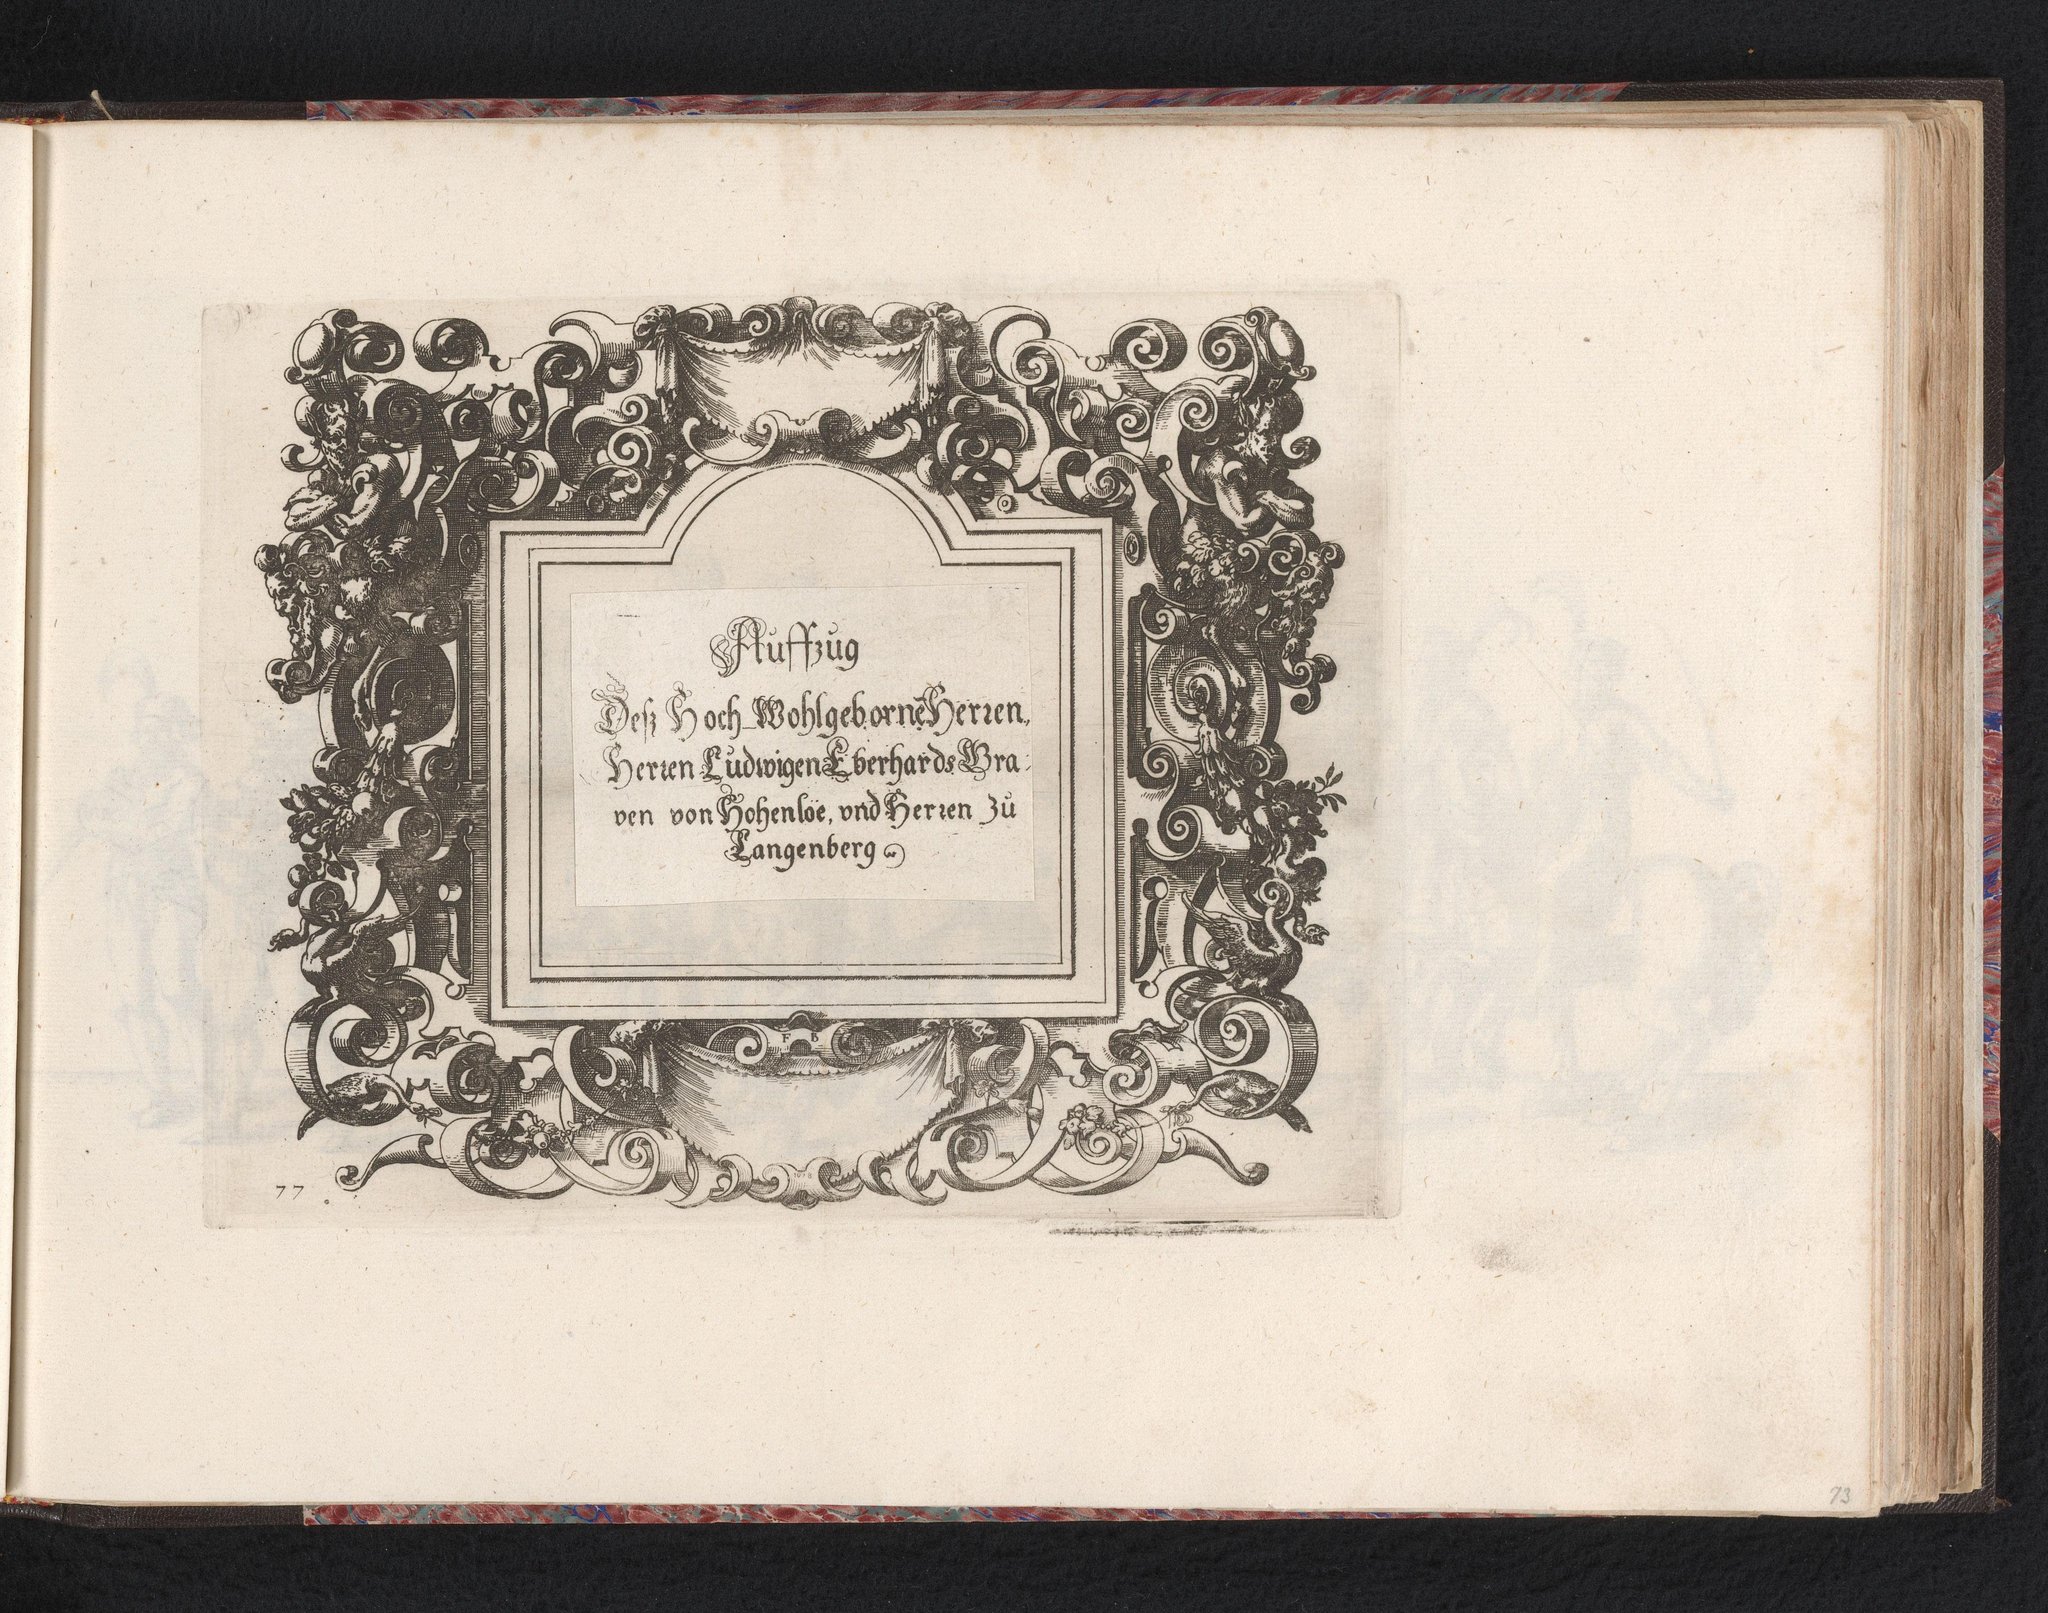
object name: album leaf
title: Band- en rolwerk met saters om een cartouche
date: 1618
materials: paper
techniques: etching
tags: earl, ludwig eberhard von hohenlohe-waldenburg-pfedelbach, satyrs, fauns, sileni, 'laub- und bandelwerk' ~ ornament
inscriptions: date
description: Genummerd: 77. Deze prent maakt deel uit van een album.